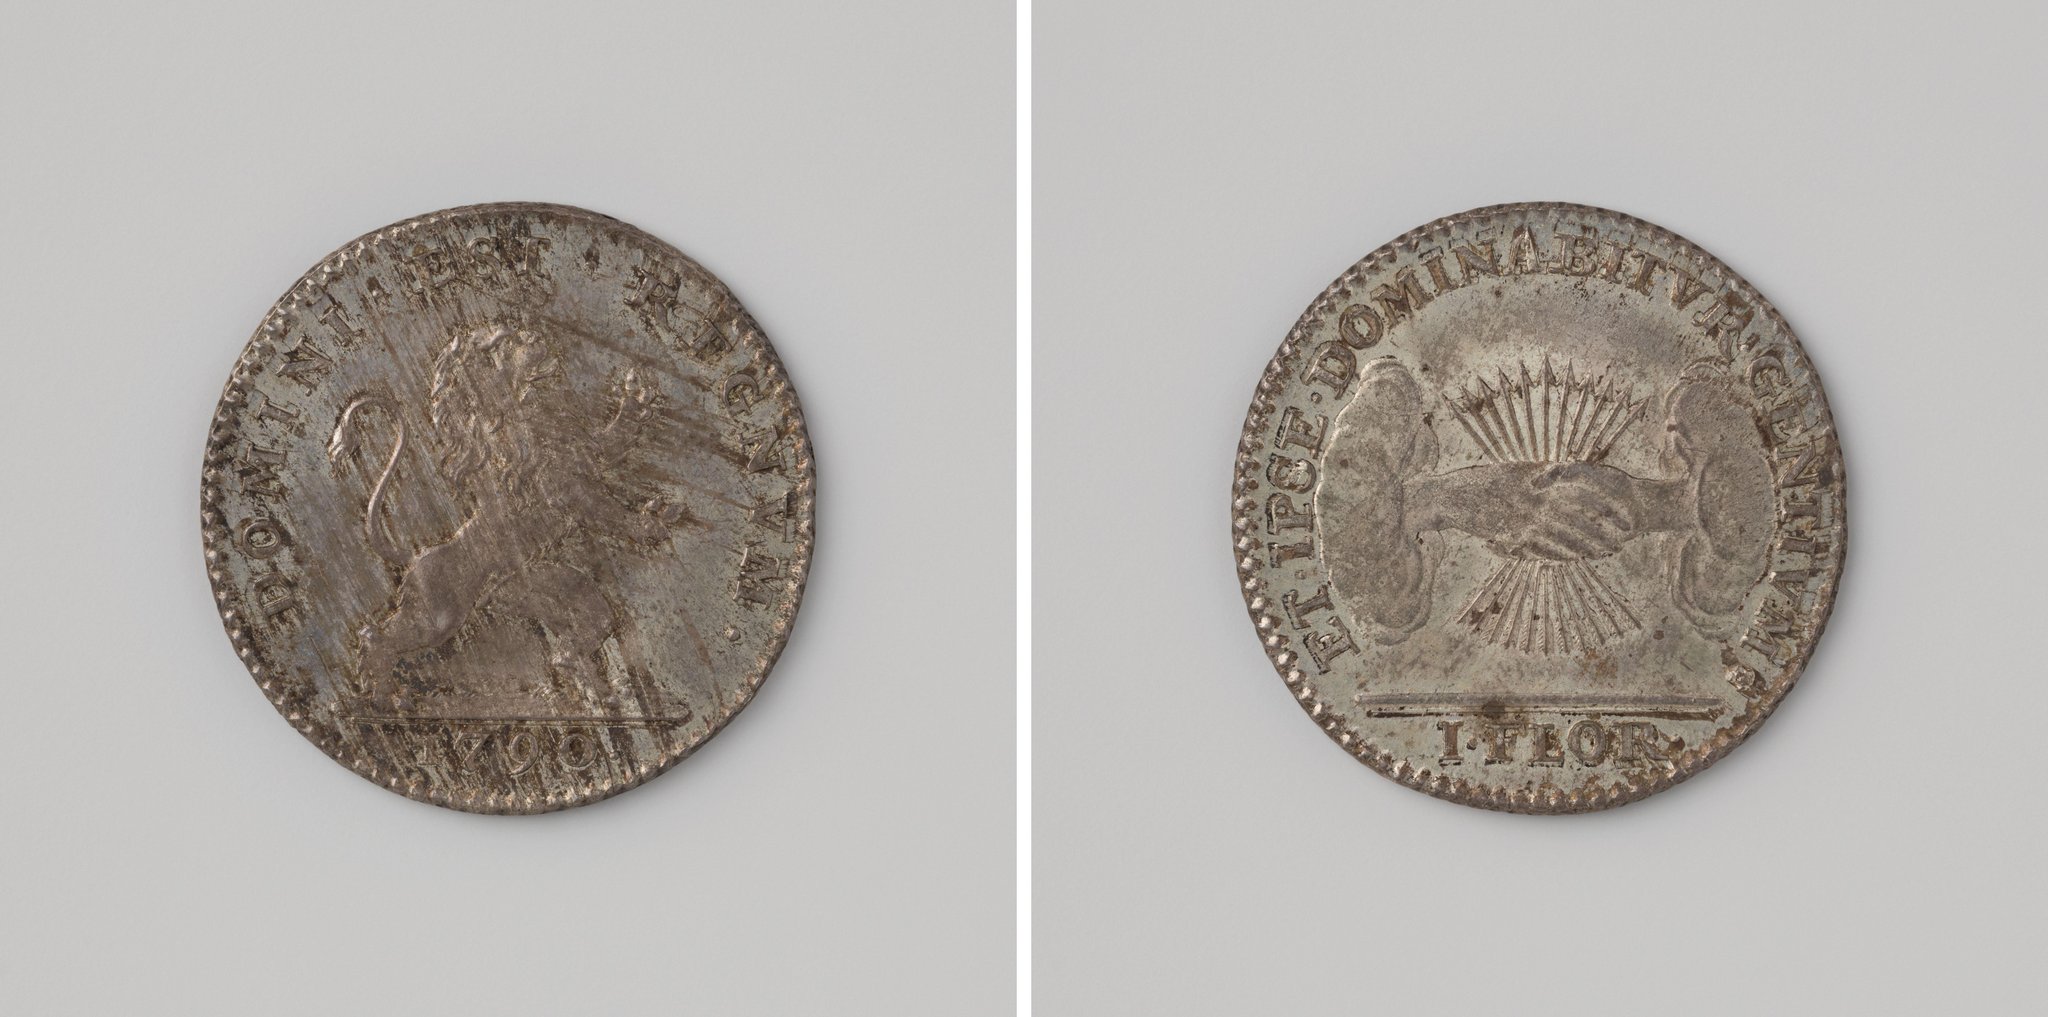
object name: coin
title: Verenigde Belgische Staten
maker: theodorus victor van berckel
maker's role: mintmaster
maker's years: 1739-1808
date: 1790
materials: silver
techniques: striking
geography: brussels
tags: belgium